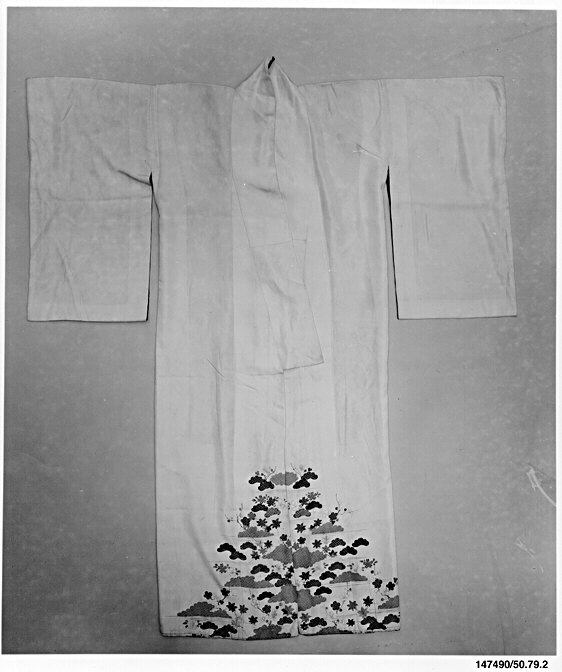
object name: woman's kimono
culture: japanese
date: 1801-1900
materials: silk